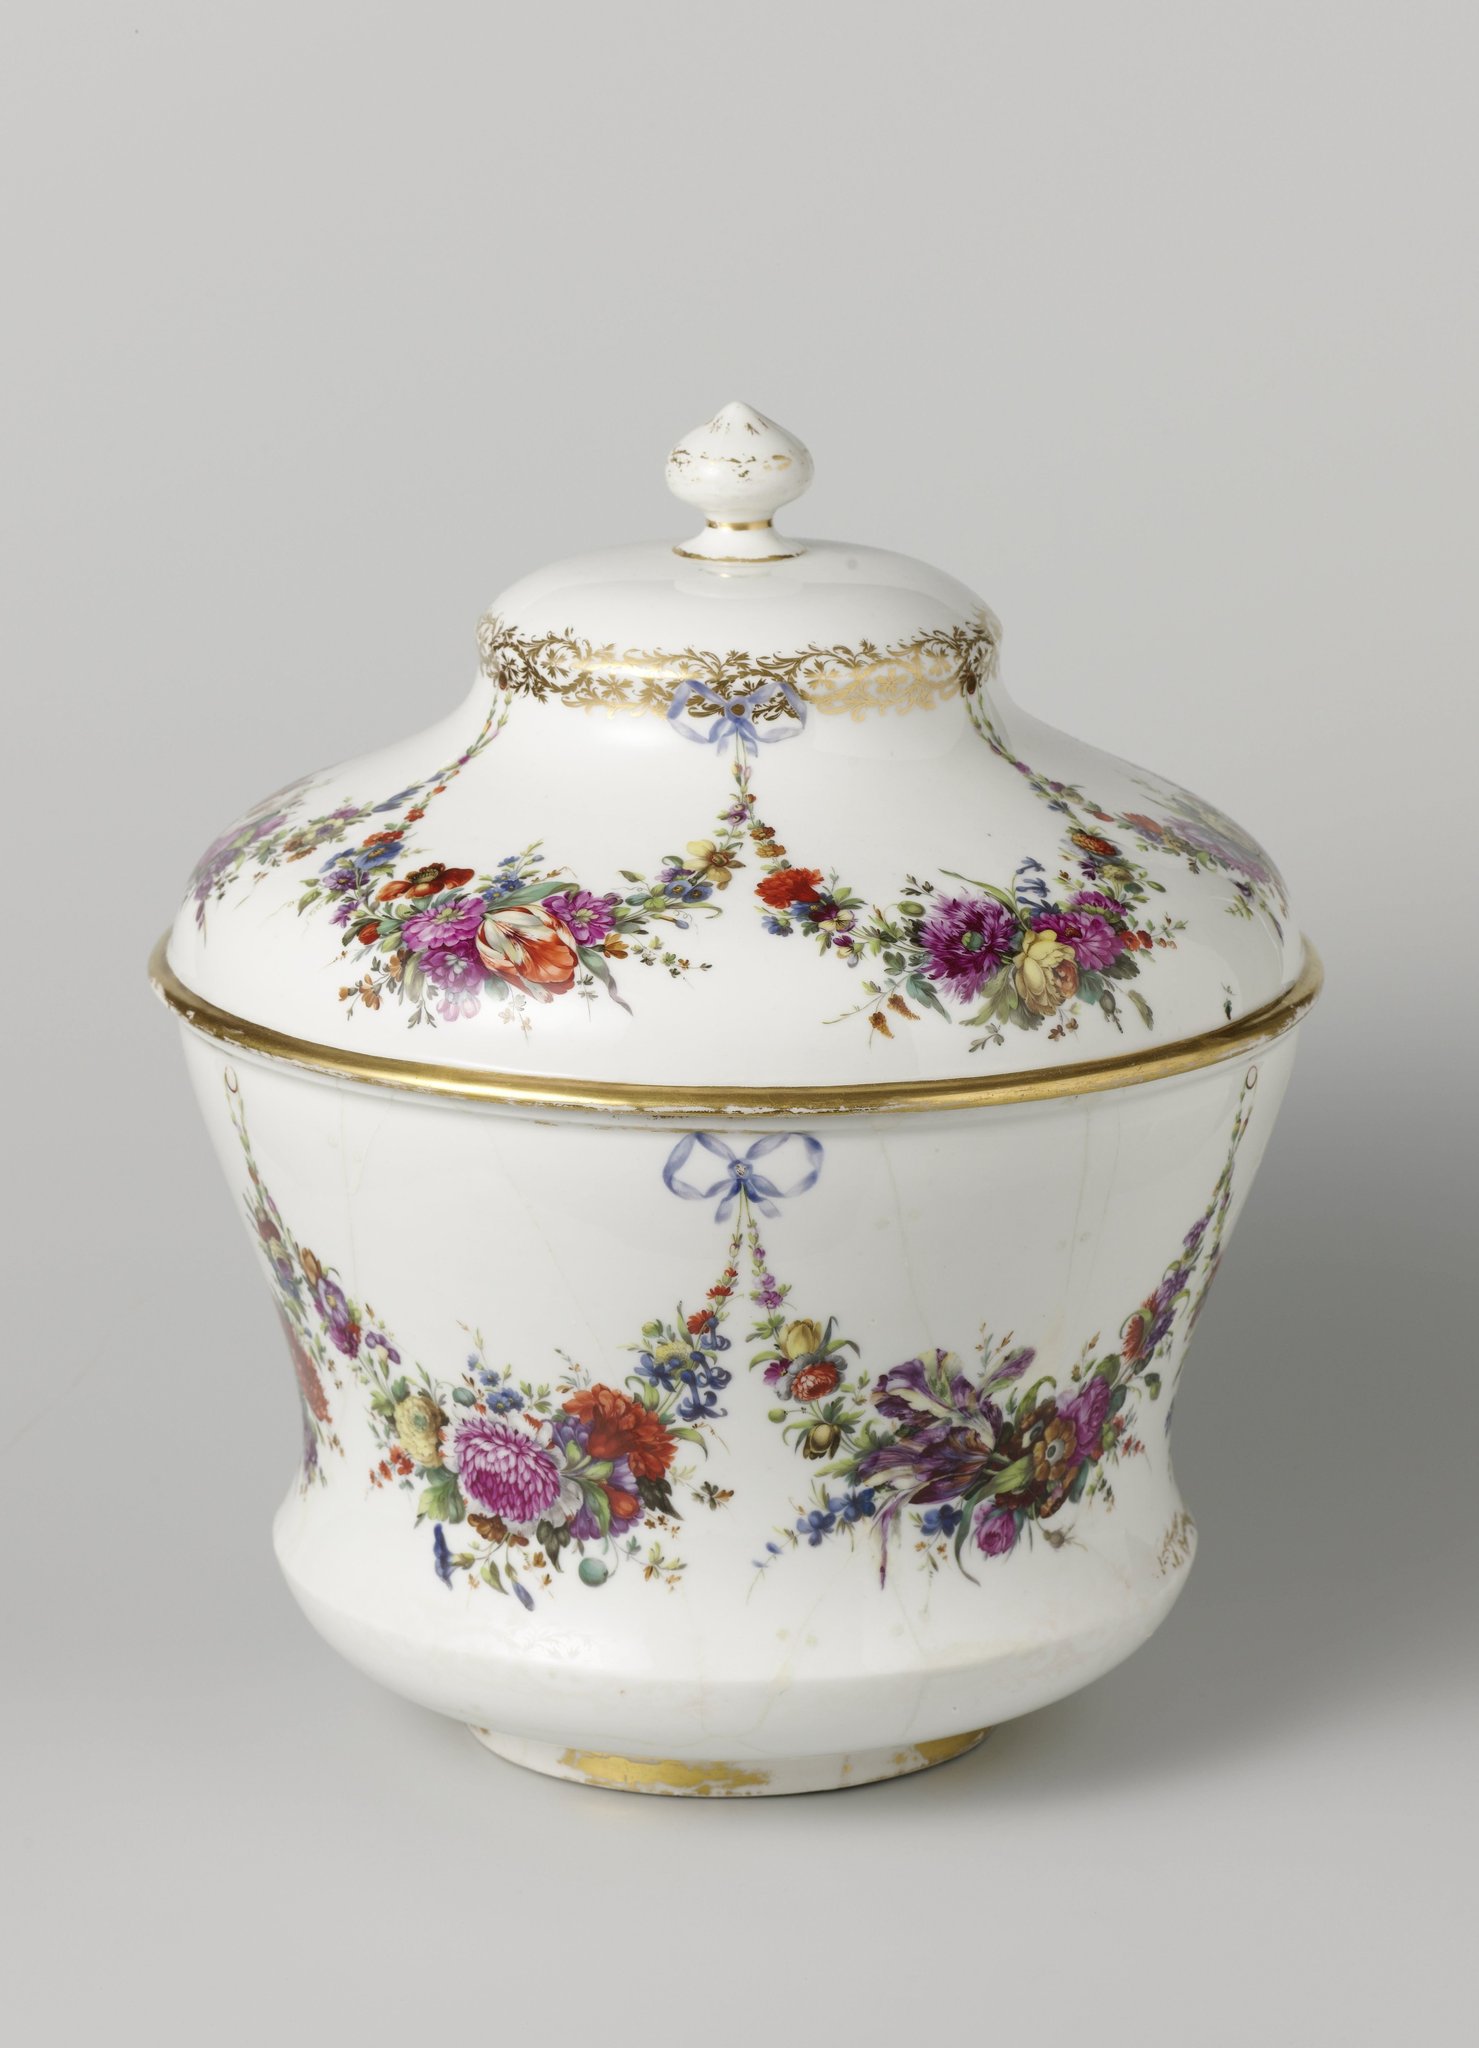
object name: punchkom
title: Punchkom, beschilderd met bloemguirlandes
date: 1778-1782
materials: porcelain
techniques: painted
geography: loosdrecht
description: Punch bowl and cover. Porcelain. Loosdrecht, c. 1778 - 1782. Factory of Joannes de Mol.